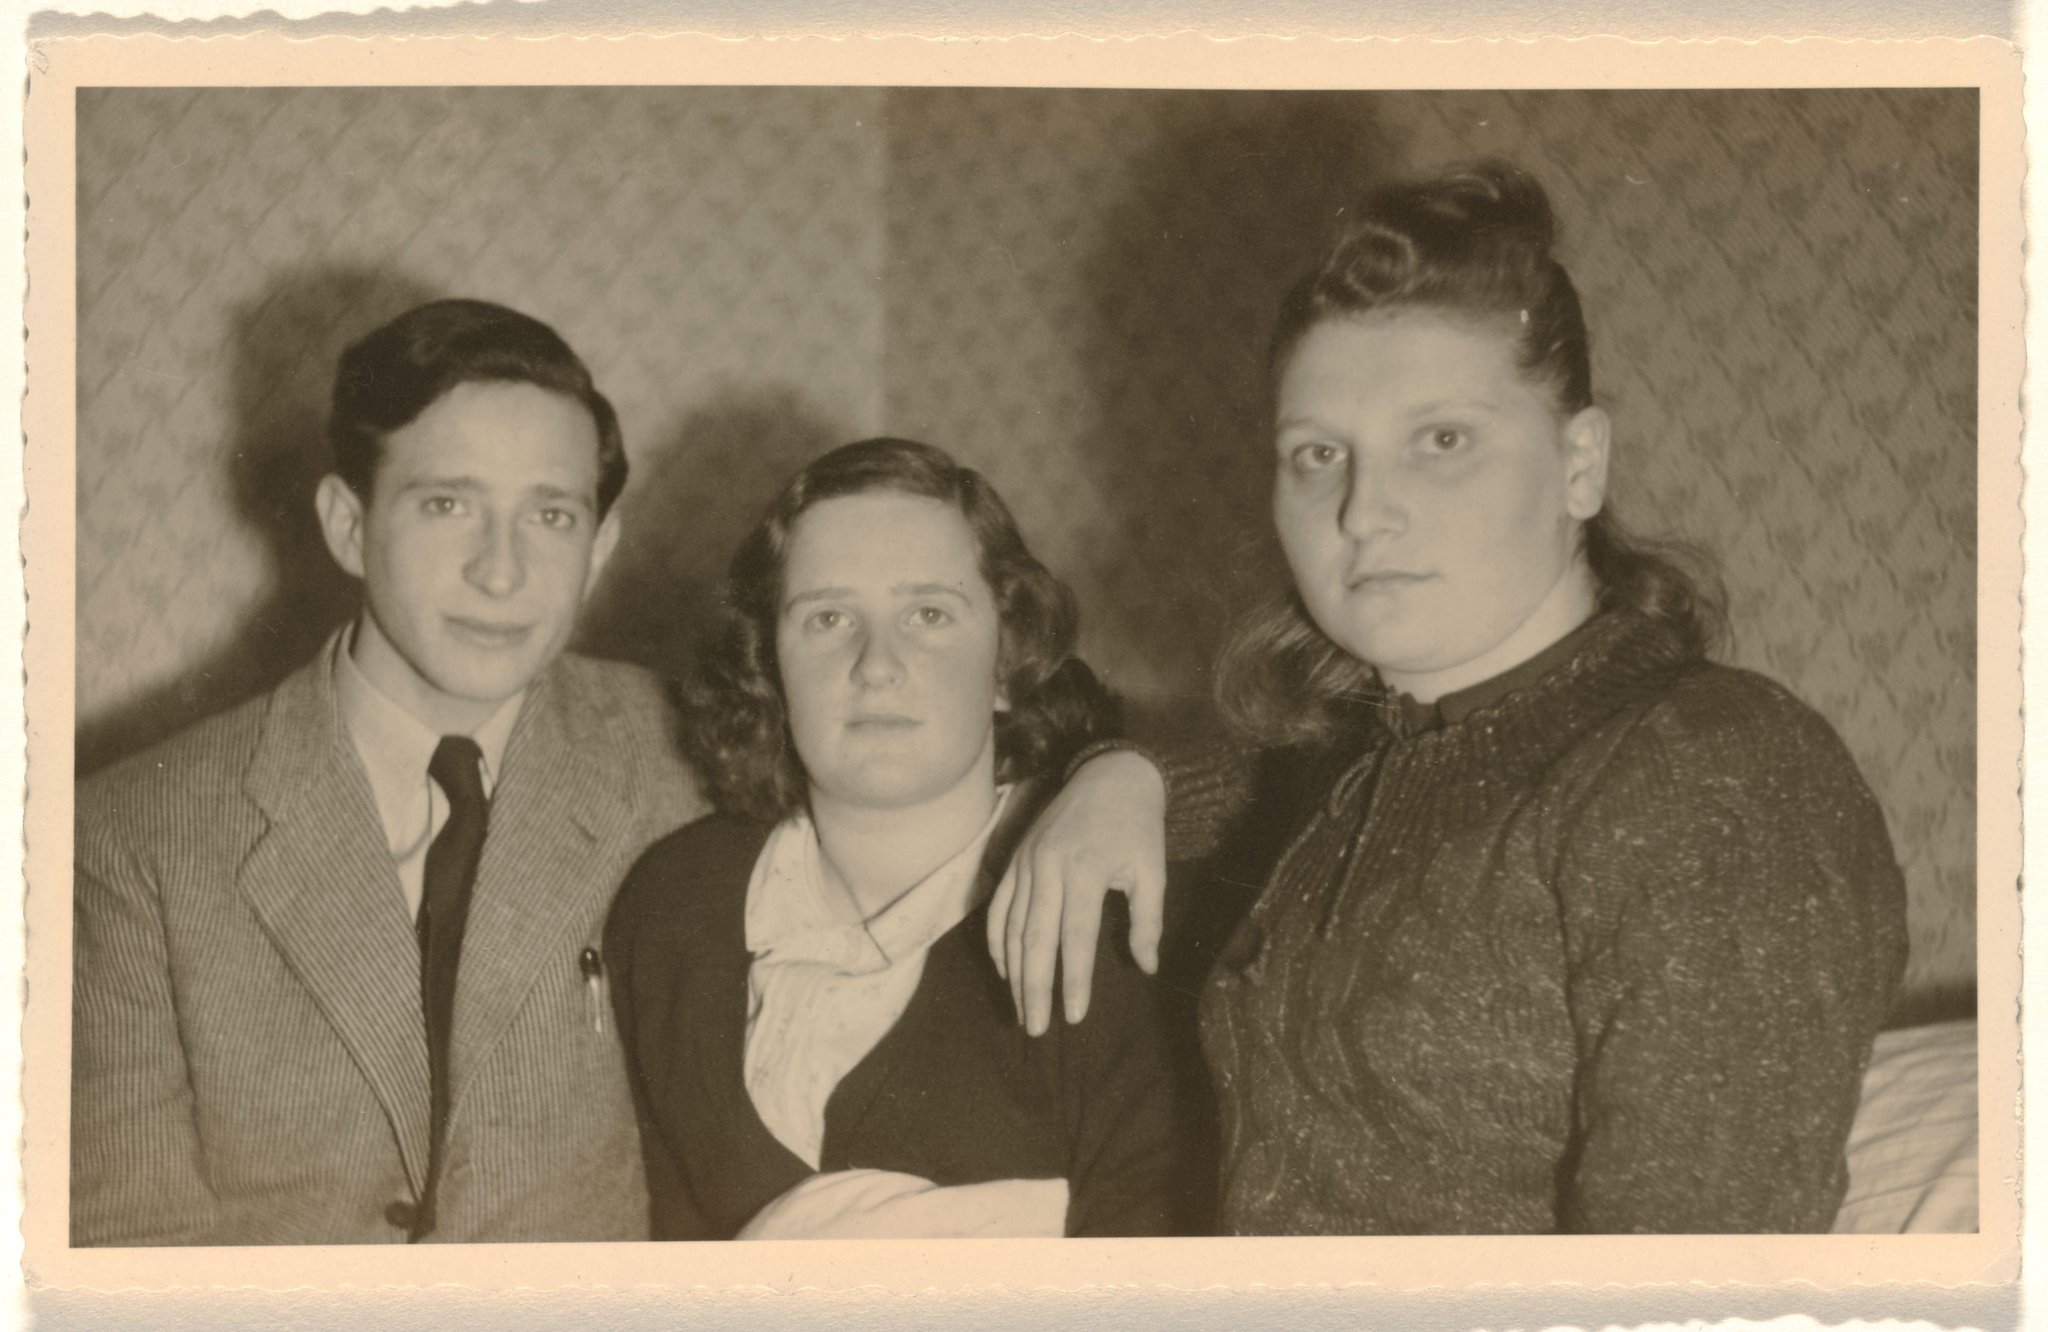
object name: photograph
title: Leo Blumensohn in gestreept colbert, Isabel Wachenheimer en een onbekende vrouw voor een ruitvorming behang, 1945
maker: Anonymous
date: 1945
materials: photographic support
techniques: gelatin silver print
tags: leiden, isabel wachenheimer-elon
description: Leo Blumensohn (links) in gestreept colbert, Isabel Wachenheimer (midden) en een onbekende vrouw (rechts) voor een ruitvorming behang.